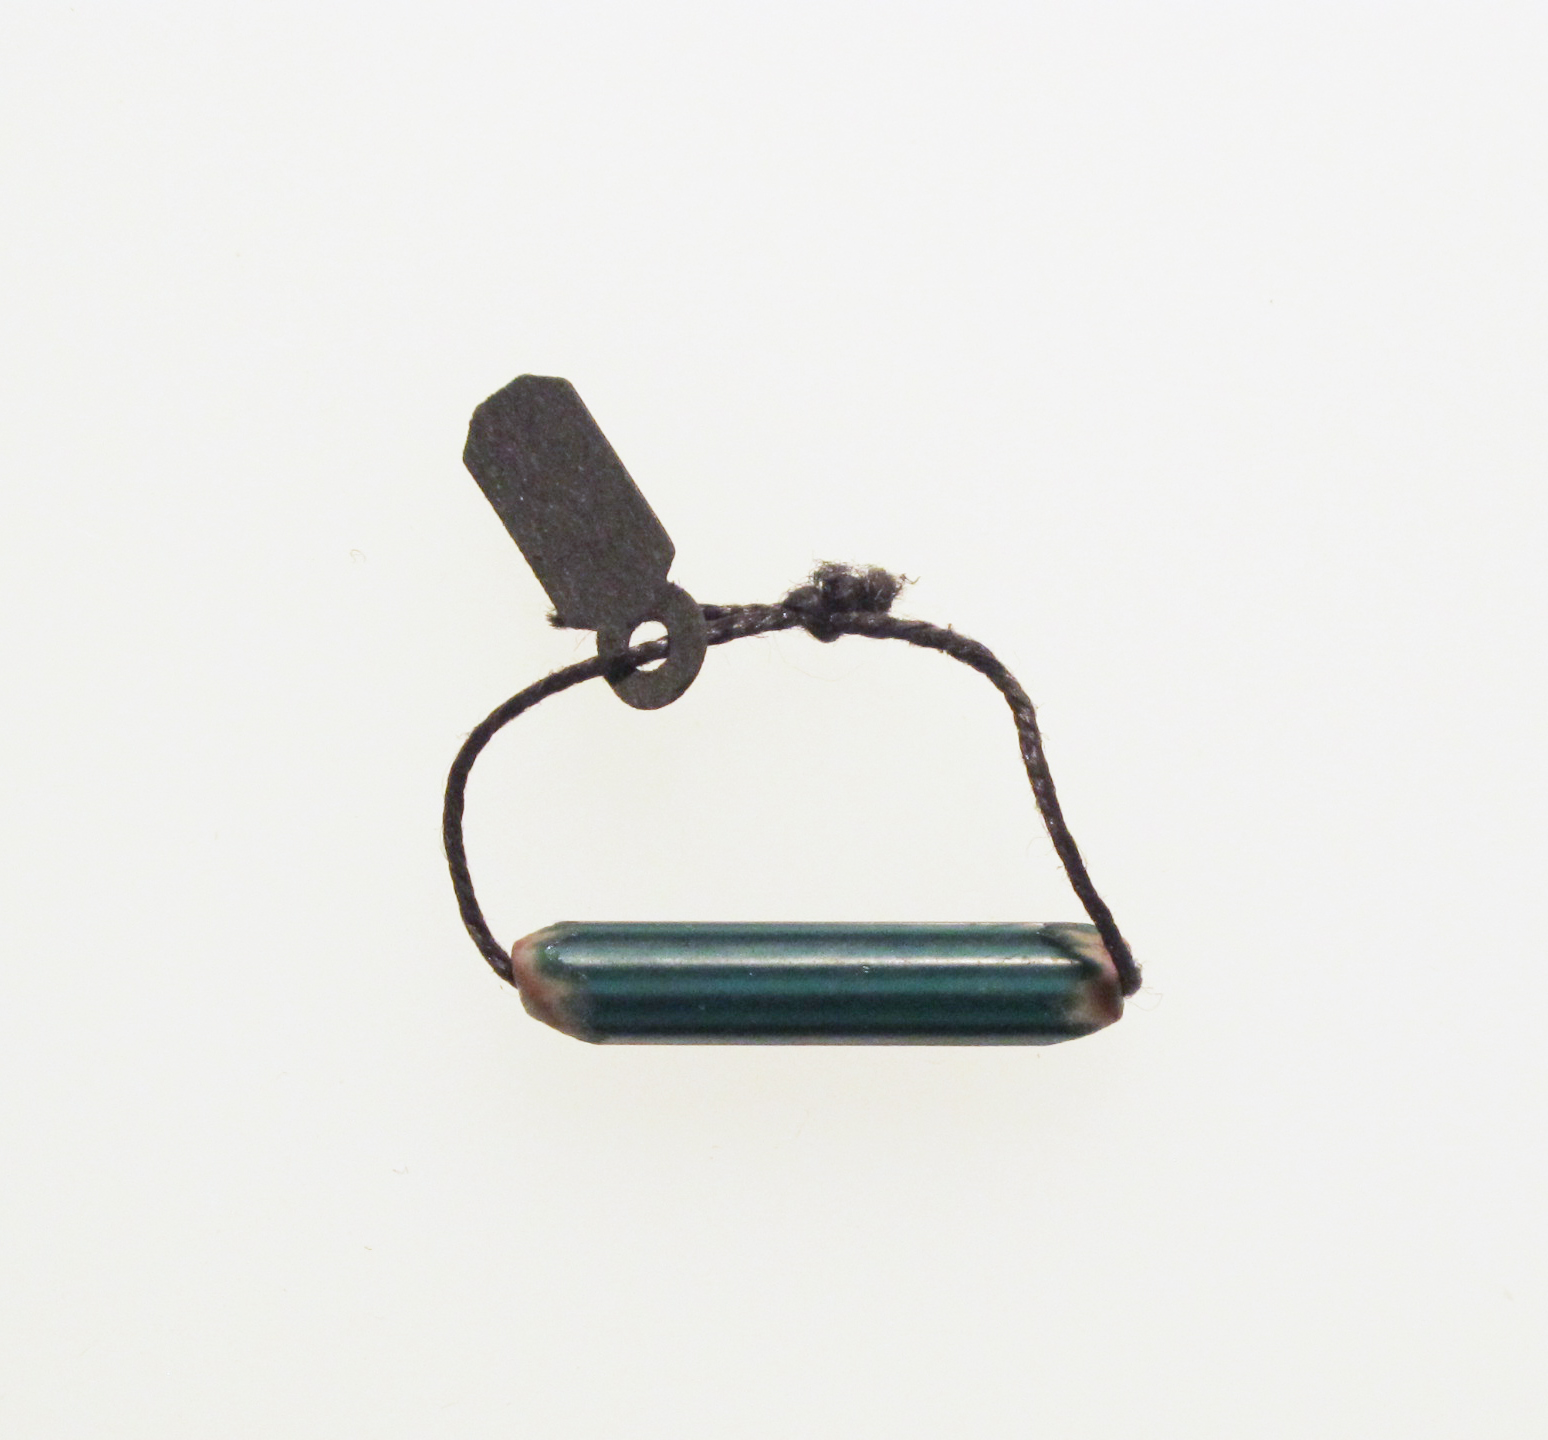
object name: bead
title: Glass bead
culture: roman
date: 301-400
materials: glass